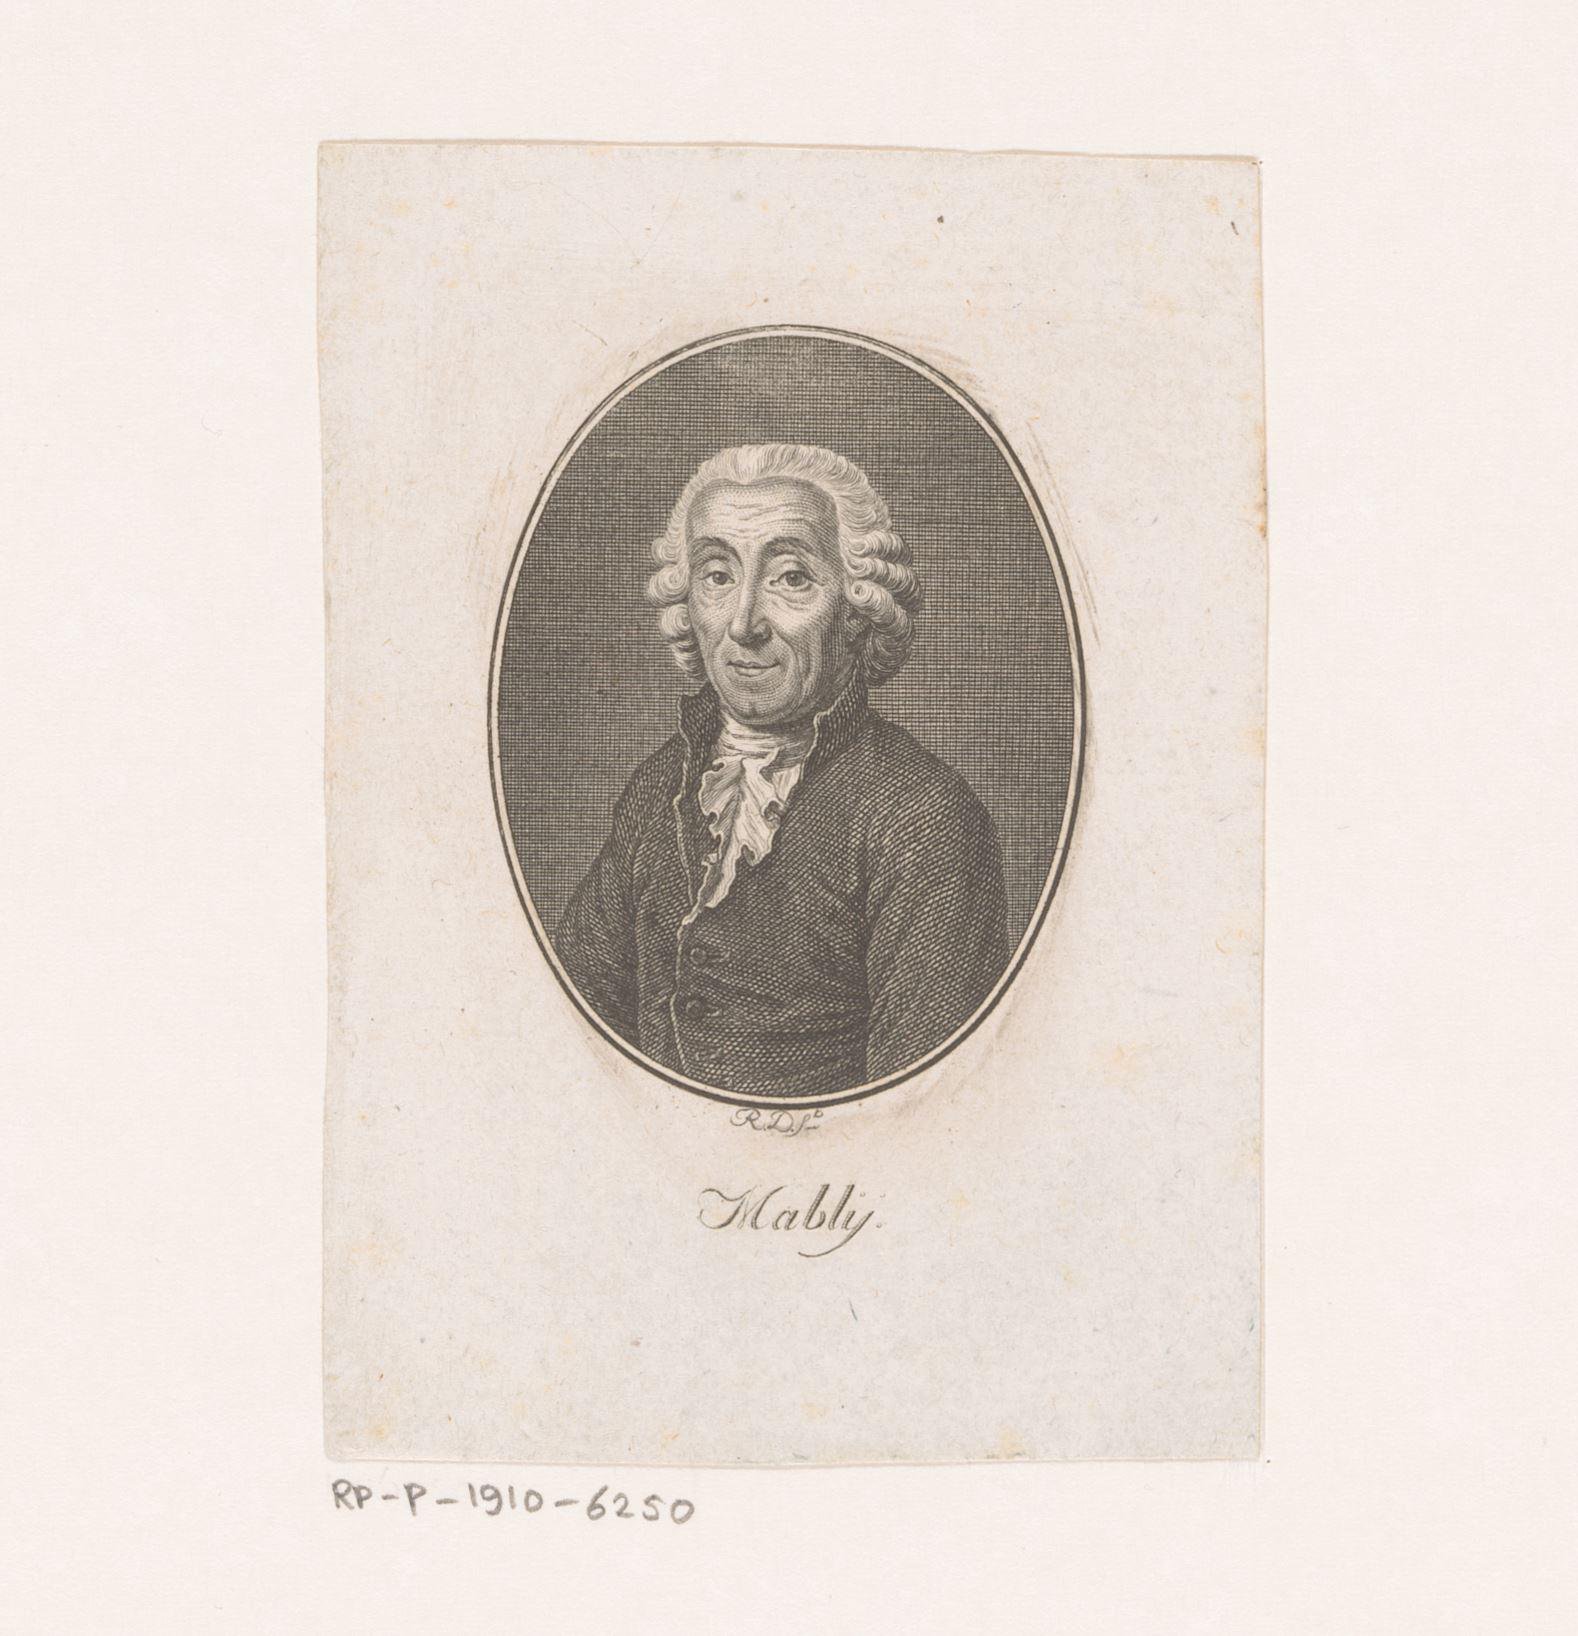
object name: print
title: Mably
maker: rené devaux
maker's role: draughtsman, goldsmith, print maker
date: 1705-1795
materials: paper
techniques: engraving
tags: paris, historical persons, portrait of a writer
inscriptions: collector's mark: Lugt 2228